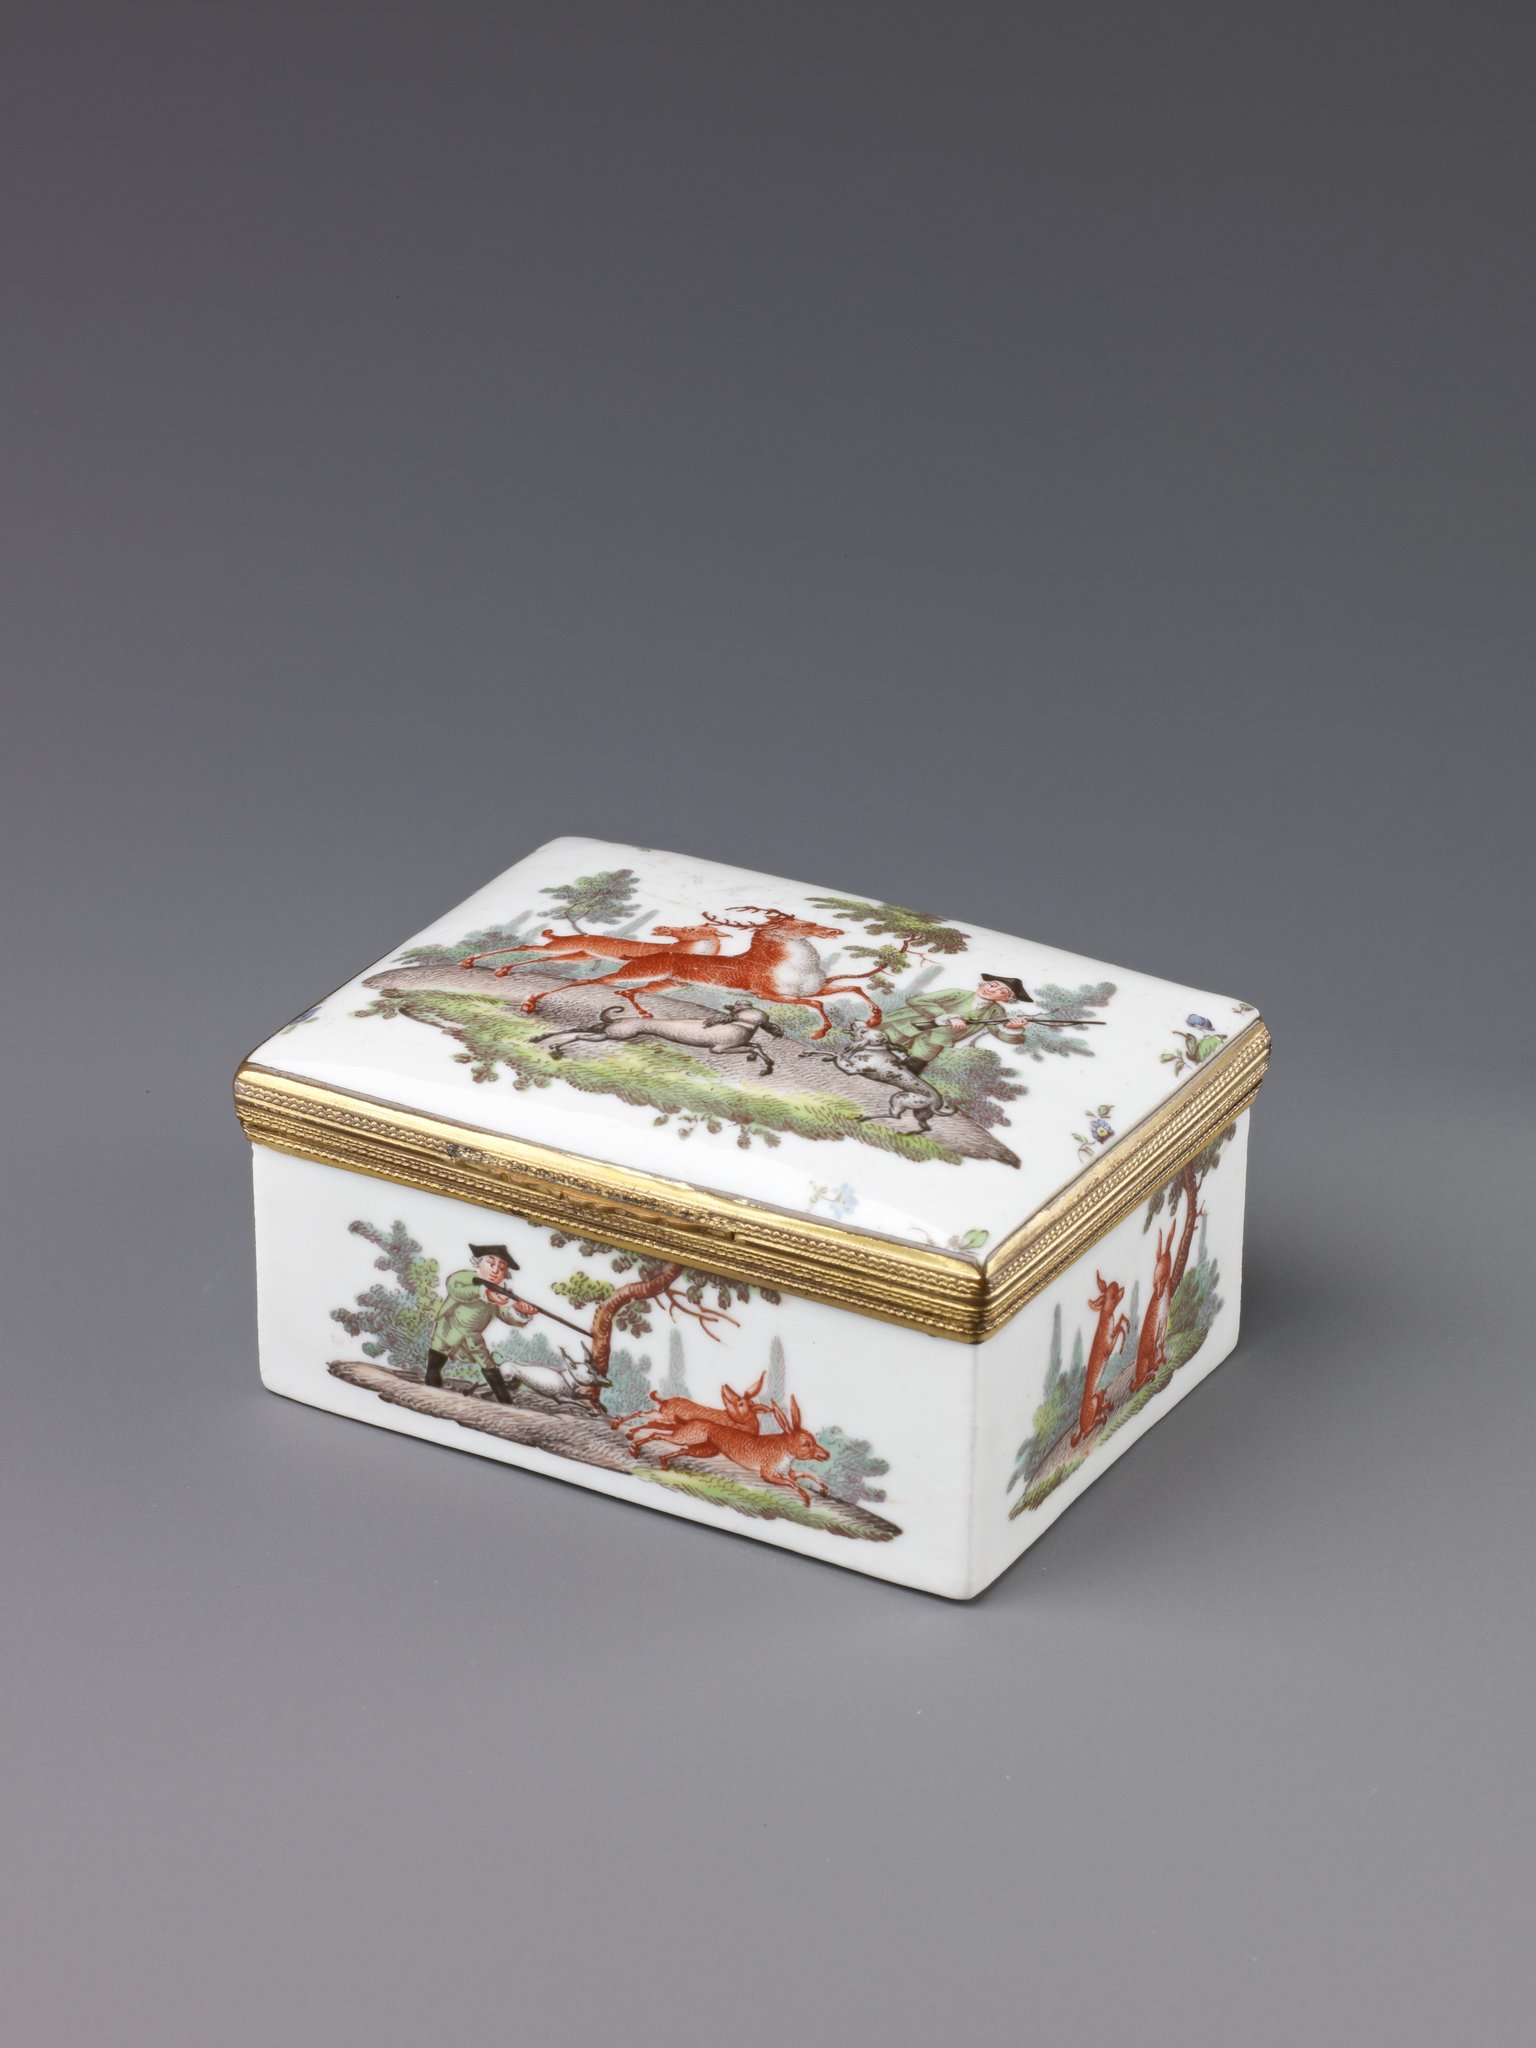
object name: snuffbox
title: Snuffbox with Hunting Scenes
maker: andreas philipp oettner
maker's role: artist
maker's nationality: german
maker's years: 1756-1787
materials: gilt copper, hard paste porcelain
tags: men,women,hunting,deer,dogs